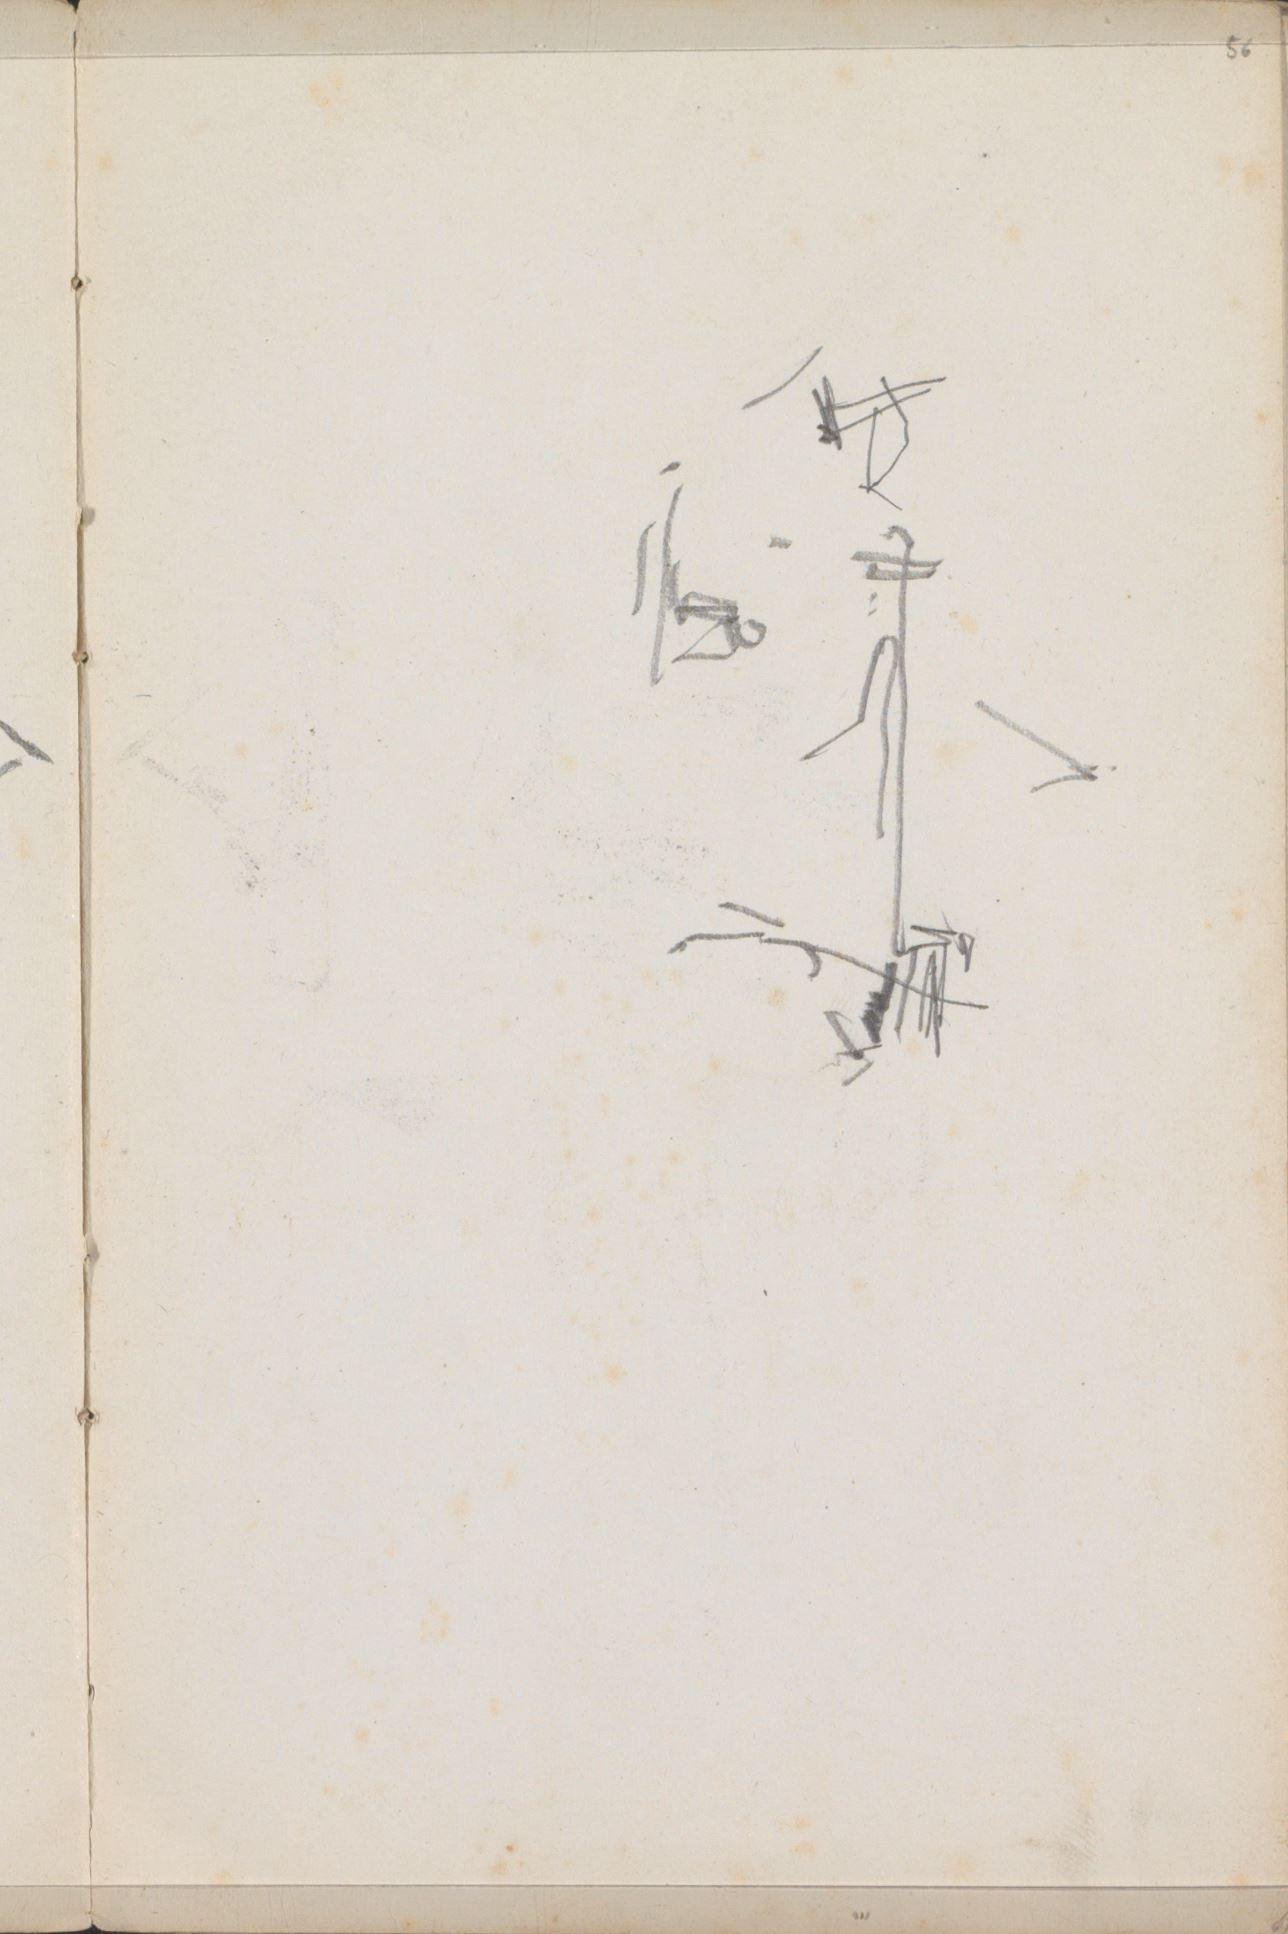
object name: sketchbook leaf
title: Studie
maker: george hendrik breitner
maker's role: draughtsman, painter, print maker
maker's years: 1857-1923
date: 1880-1882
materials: paper, pencil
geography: south holland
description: Pagina 56 uit een schetsboek met 72 bladen.